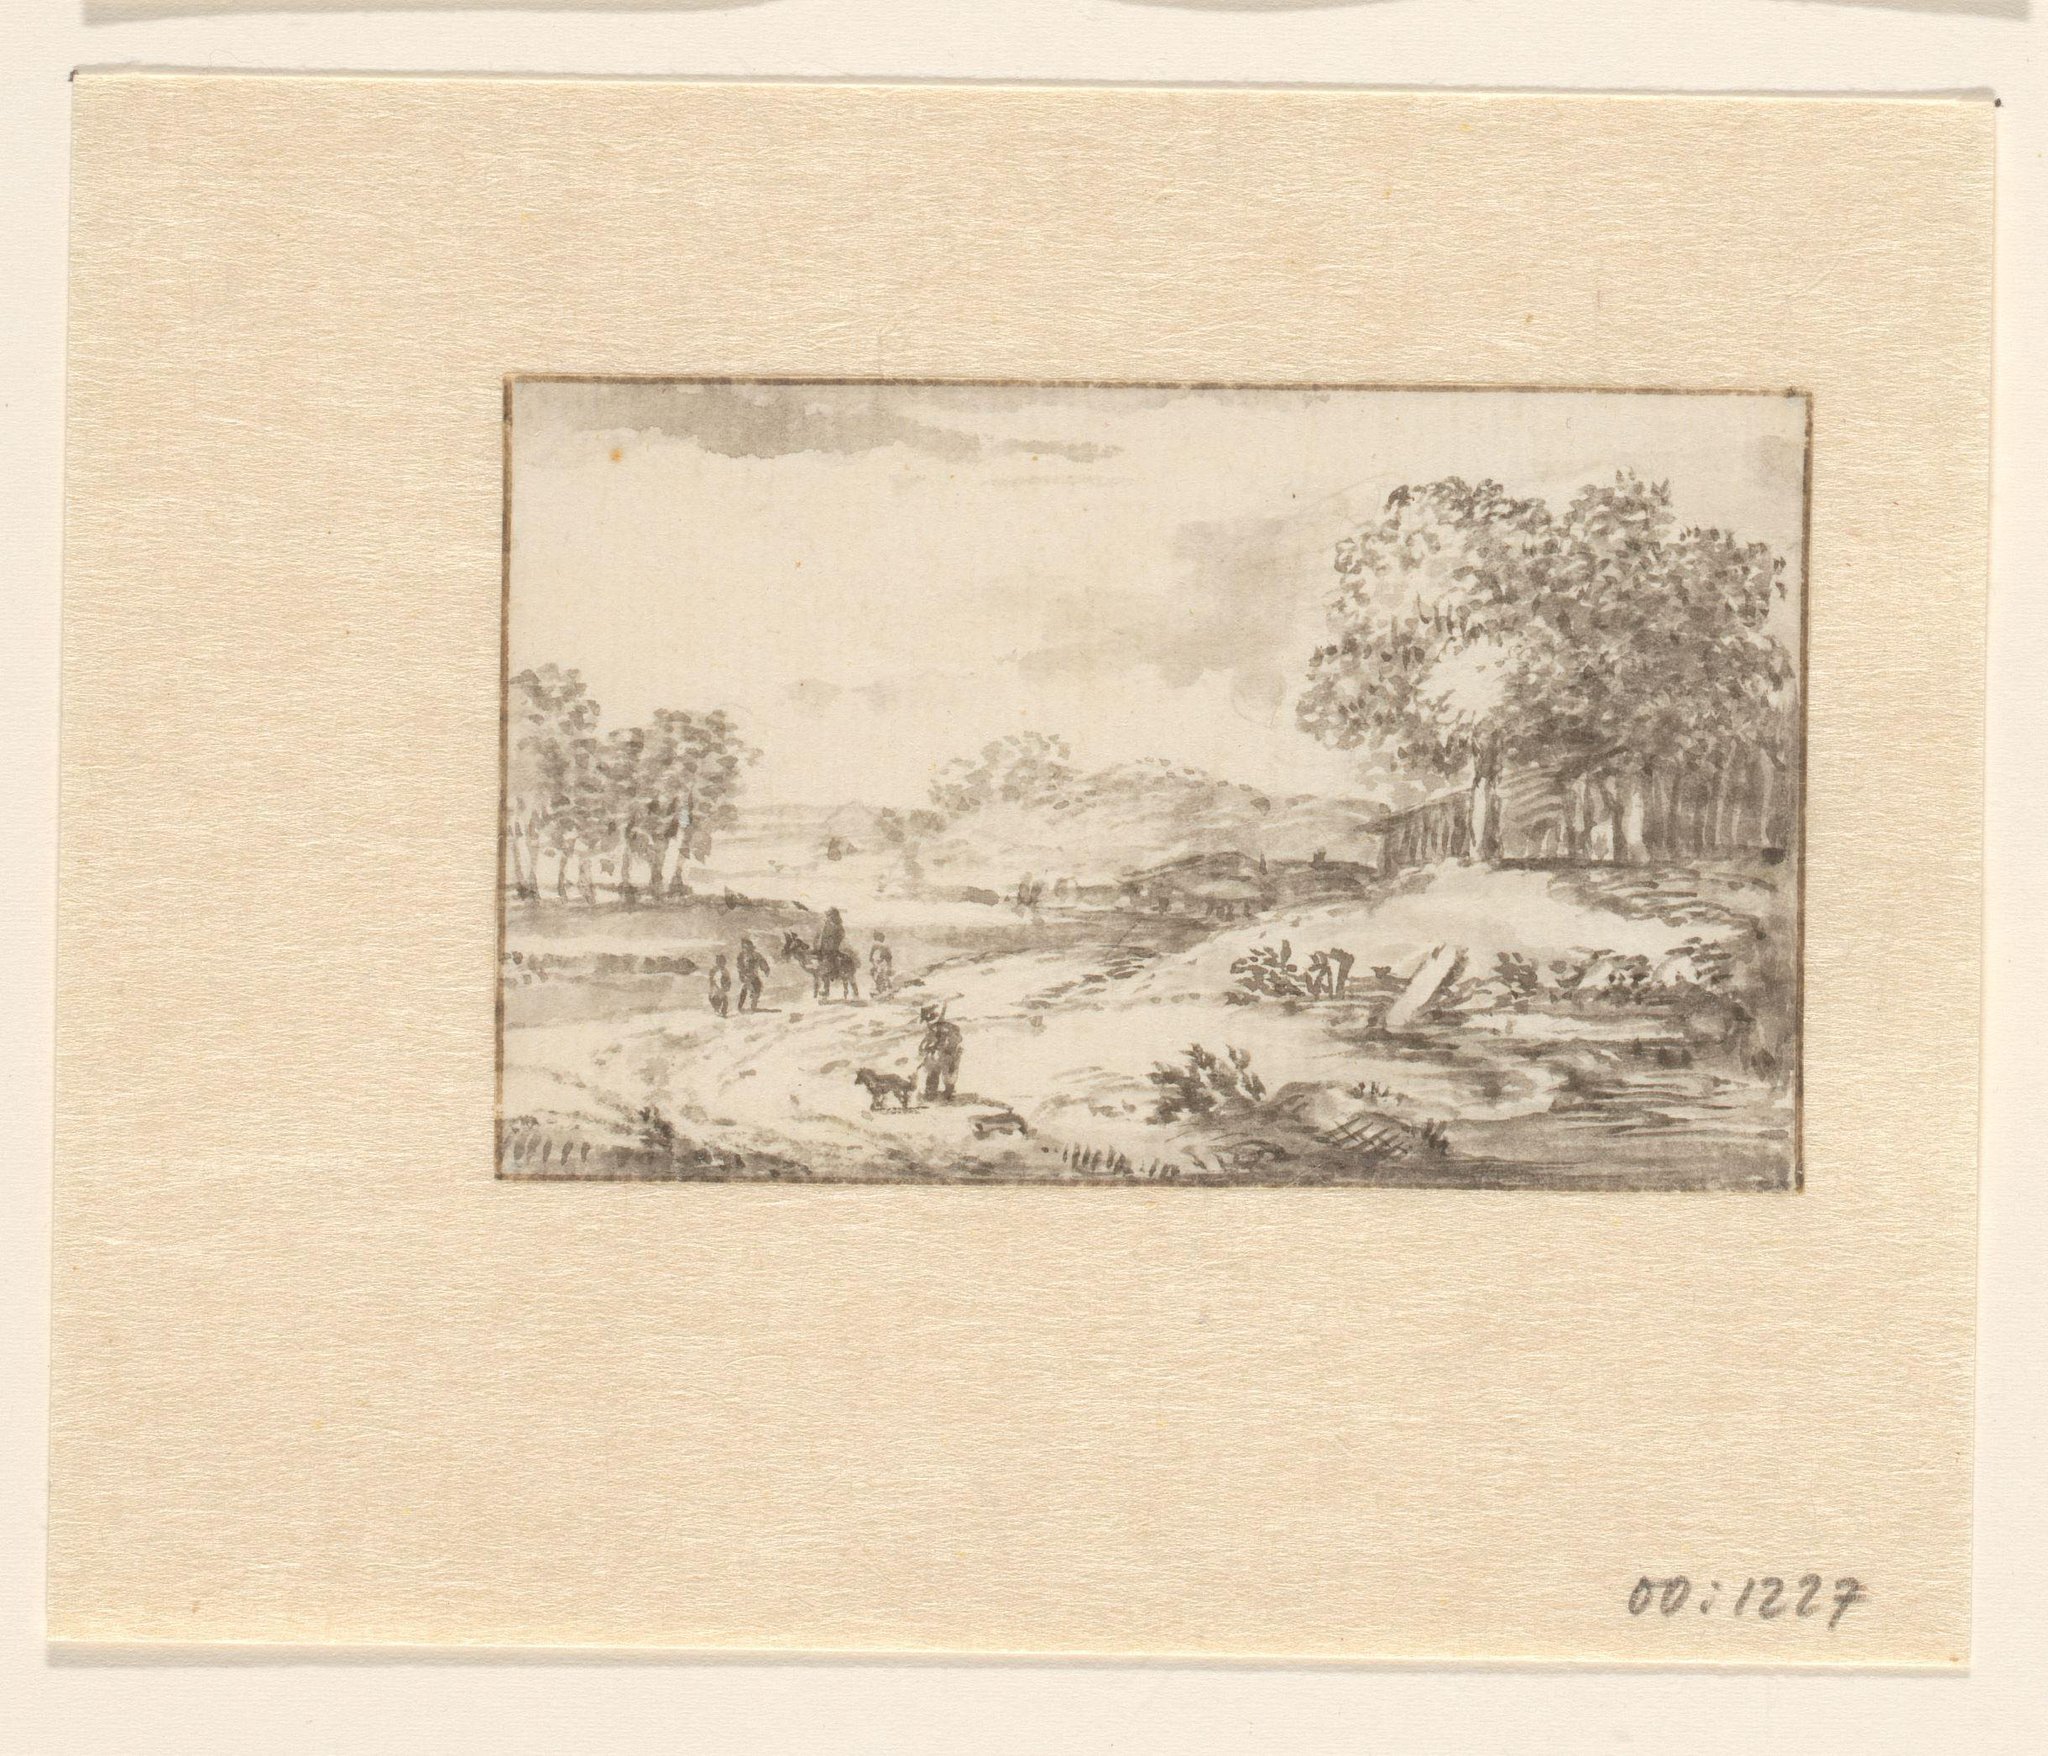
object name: drawing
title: Landschap met ruiter op een zandweg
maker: valentijn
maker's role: draughtsman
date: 1700-1800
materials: ink, paper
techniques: brush, pen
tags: landscapes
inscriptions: inscription: ‘Valentijn 5’